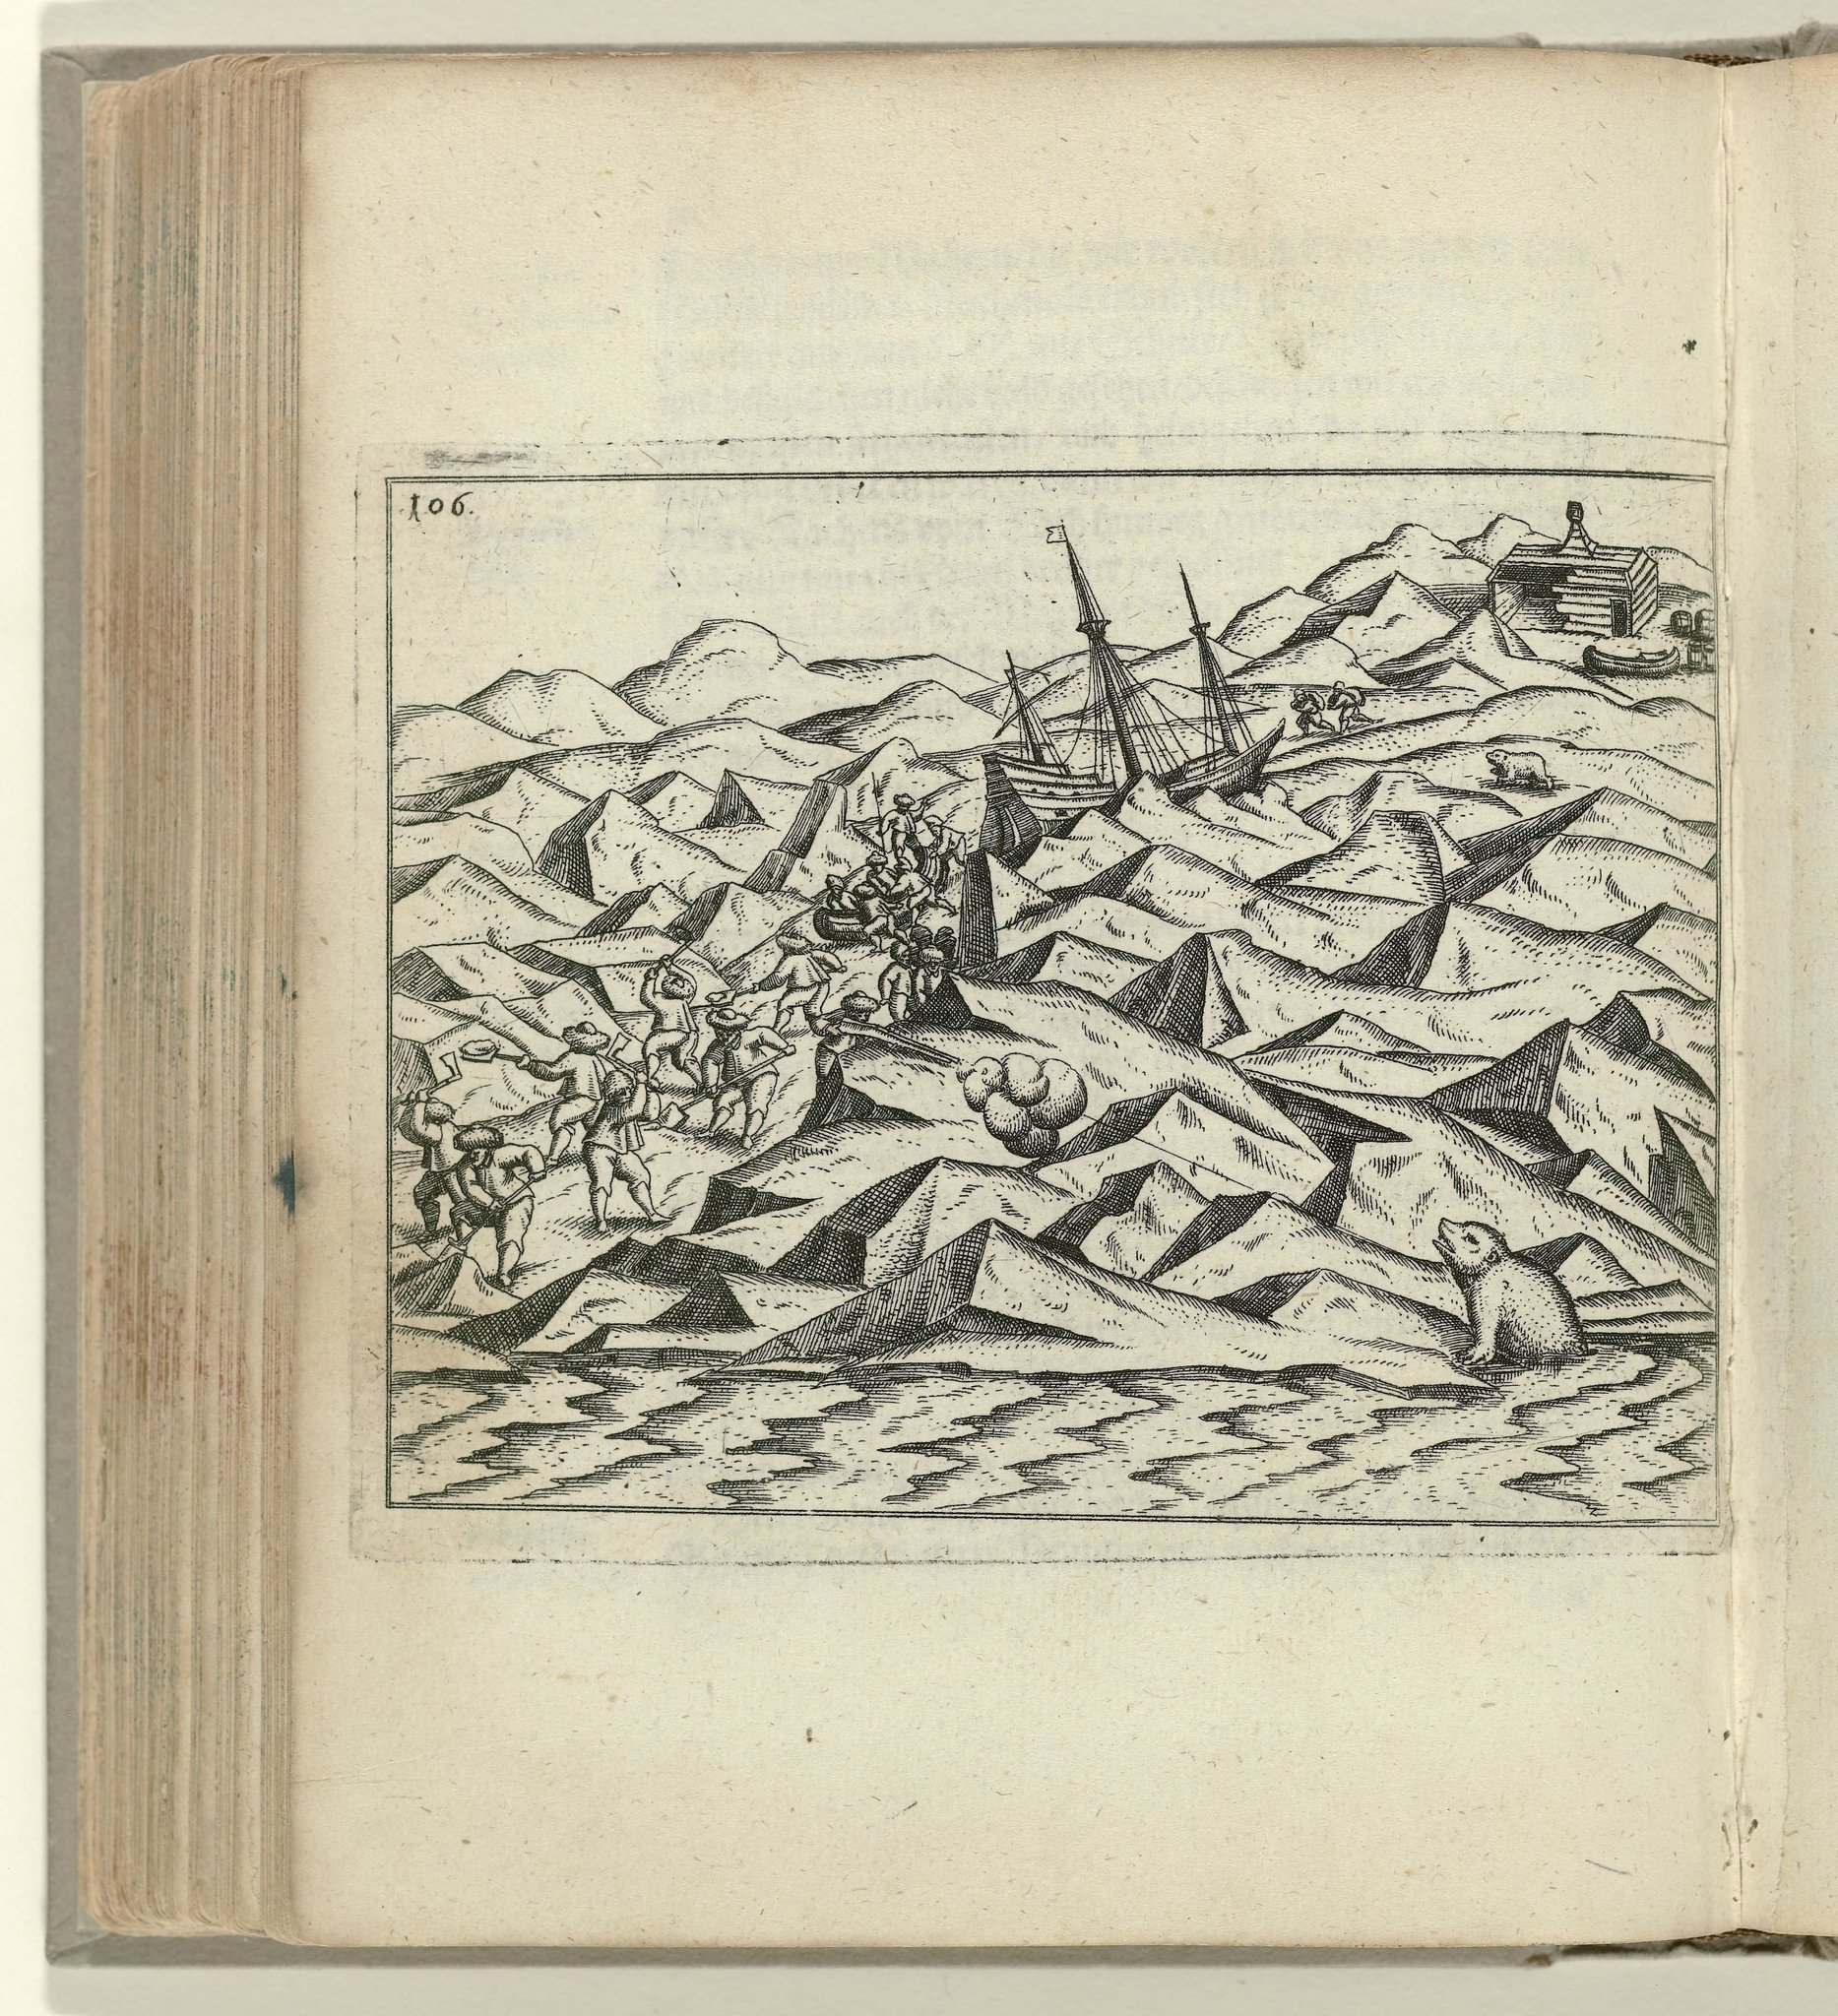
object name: print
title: Het vrijmaken van een pad door het ijs naar de zee, 1597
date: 1598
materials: paper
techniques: engraving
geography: nuremberg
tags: willem barendsz., amsterdam, jacob van heemskerck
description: Het vrijmaken van een pad door het ijs naar de zee, 12 juni 1597. Het hakbijlen en spaden wordt een pad door het ijs gemaakt waarover de sloep naar zee gesleept kan worden. Op de voorgrond wordt een ijsbeer geschoten. Tegenover pagina 101 in: 'Warhafftige Relation. Der dreyen newen unerhörten seltzamen Schiffart so die Holländischen und Seeländischen Schiff....Anno 1594, 1595 und 1596 verricht' (1598).